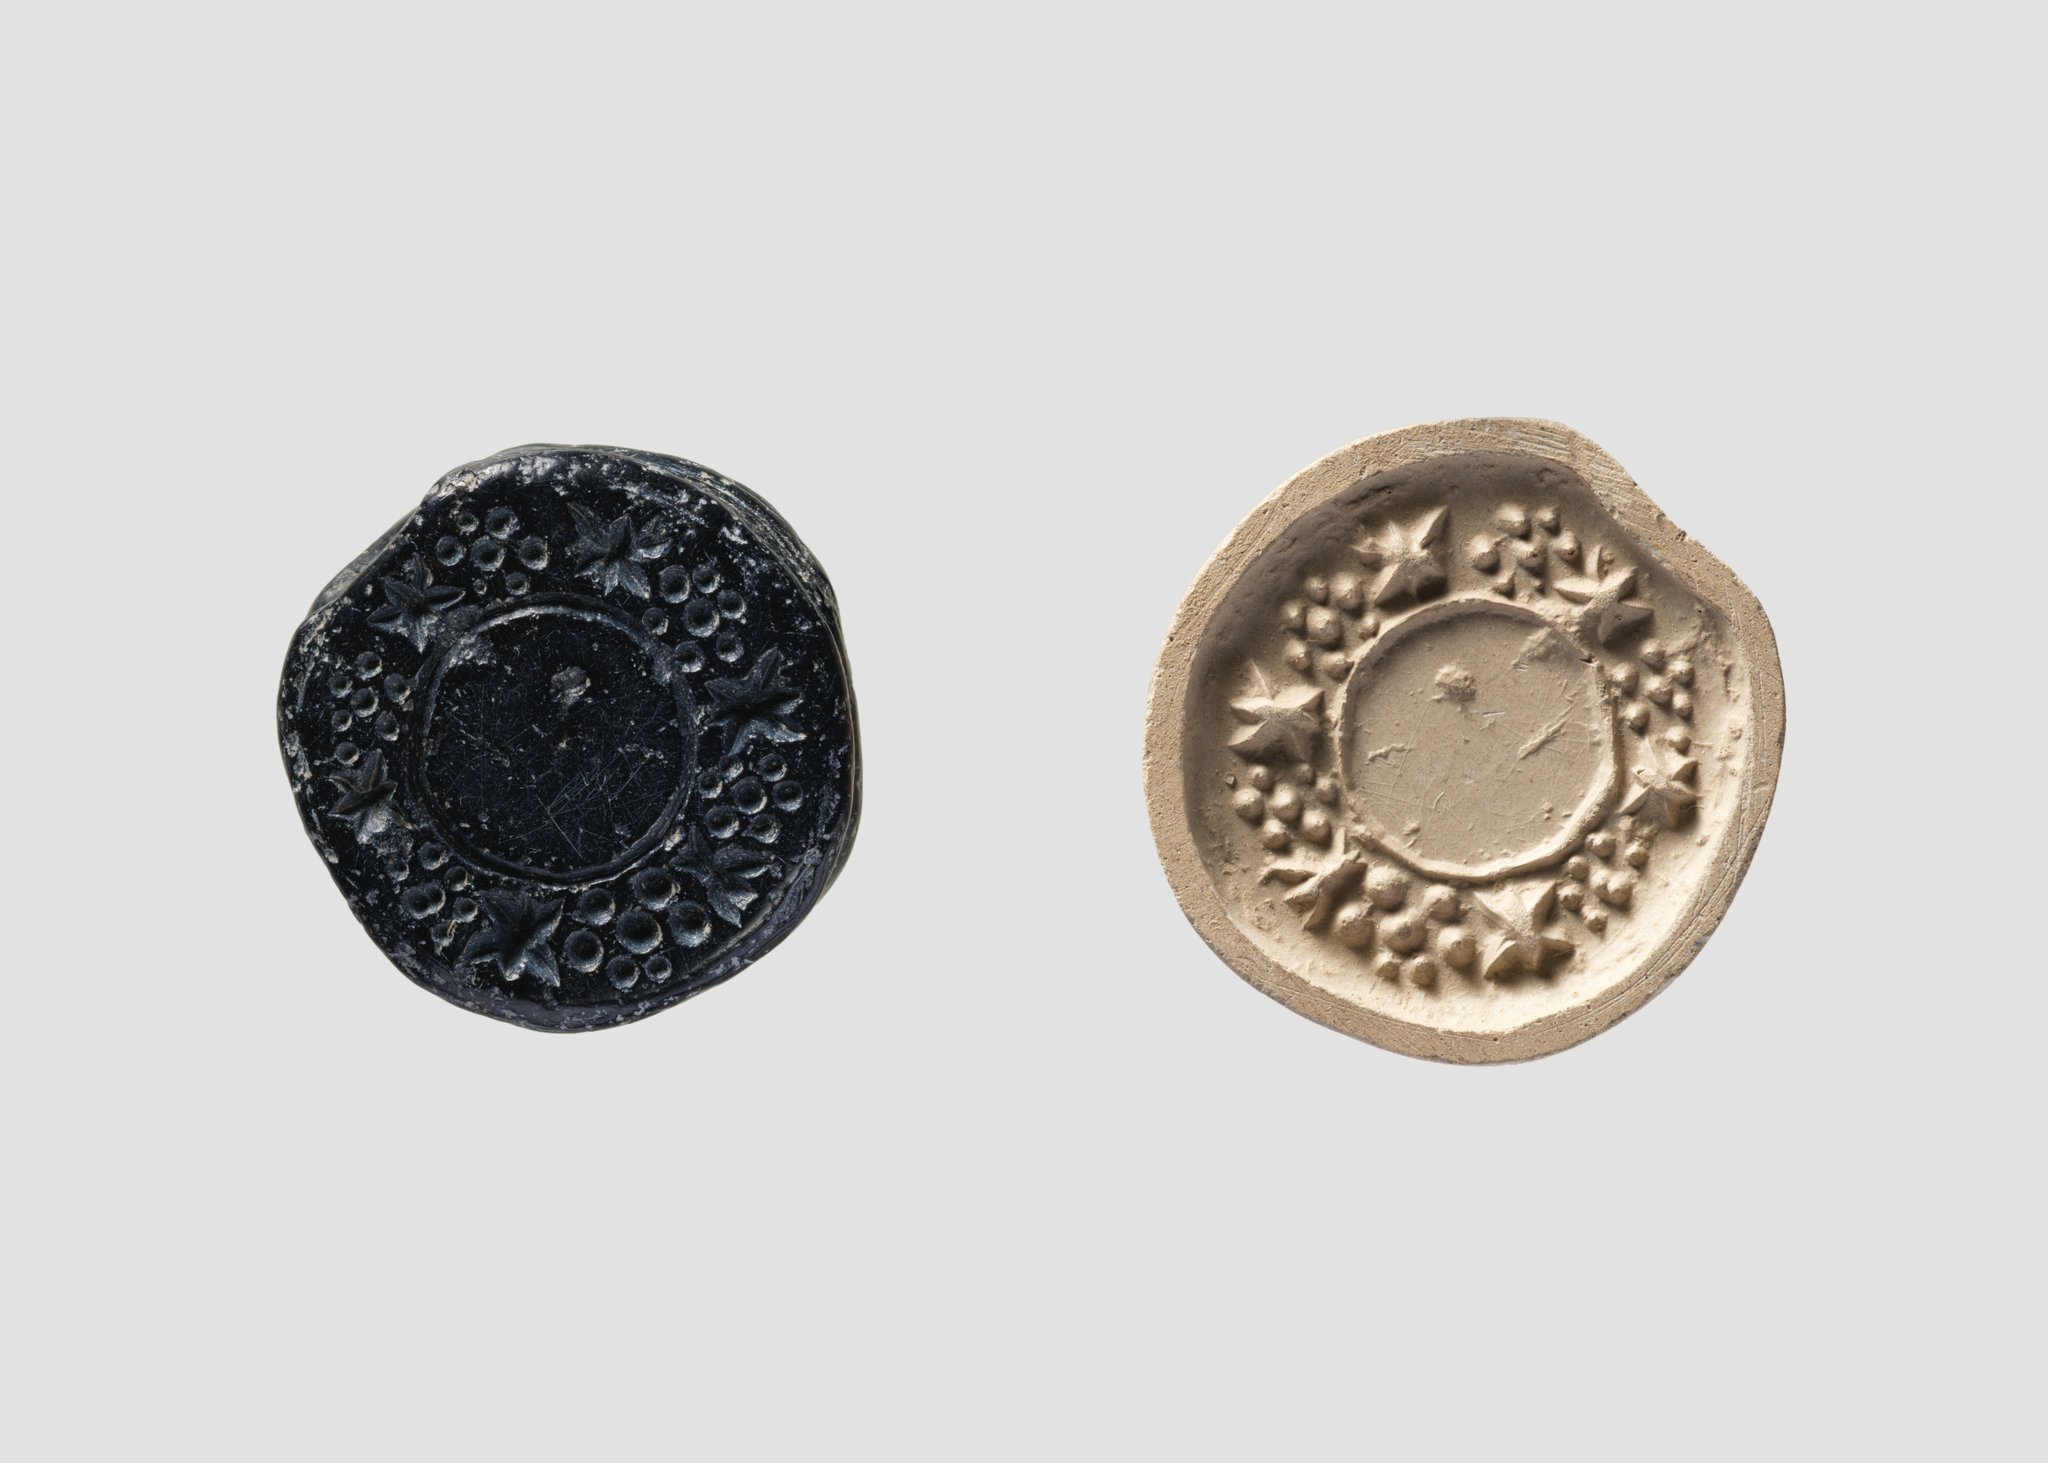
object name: stamp seal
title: Cupola seal engraved on back and face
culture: hittite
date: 1400-1200 BCE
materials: stone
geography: syria or anatolia